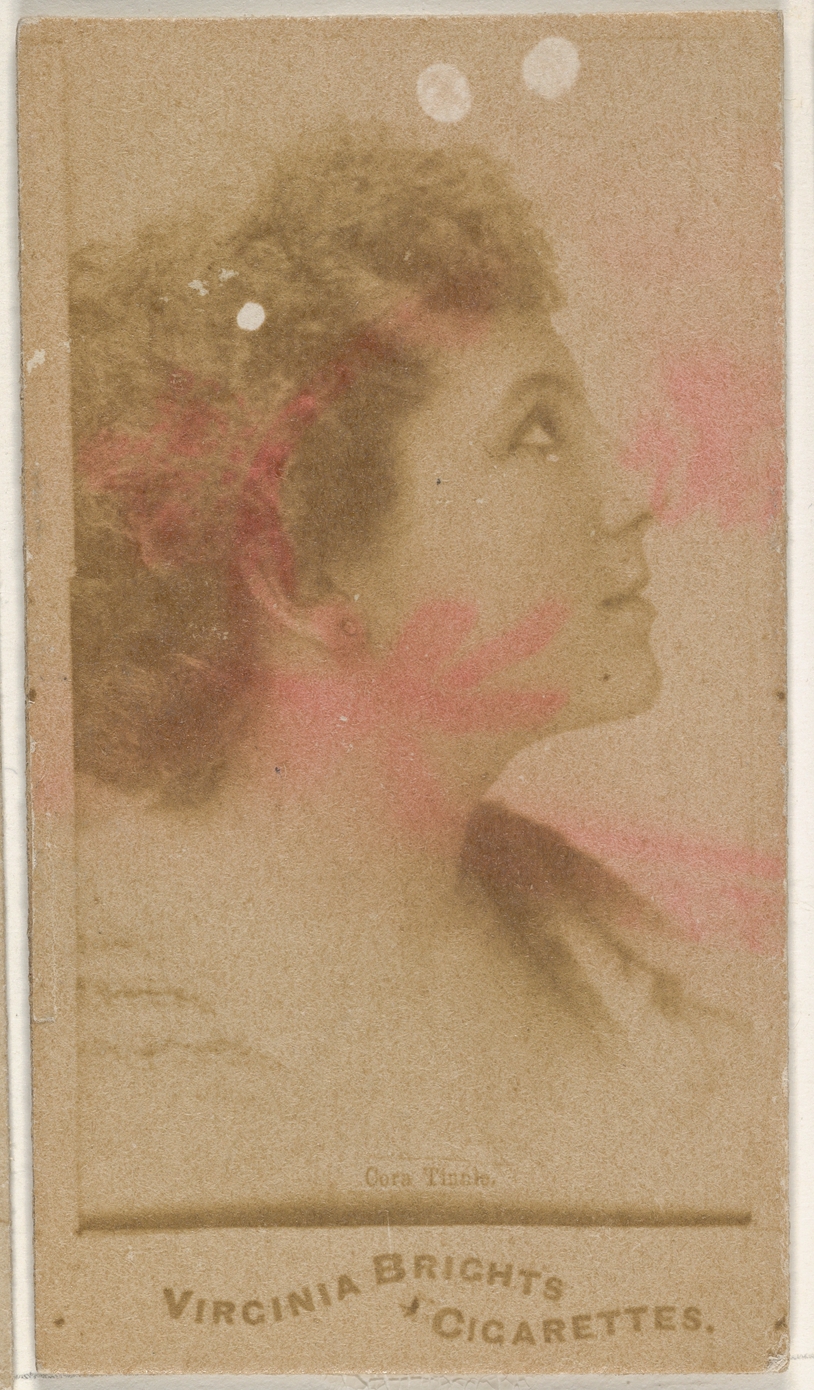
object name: photograph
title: Cora Tisch, from the Actors and Actresses series (N45, Type 1) for Virginia Brights Cigarettes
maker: allen & ginter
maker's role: publisher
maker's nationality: american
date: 1888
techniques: albumen silver print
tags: portraits,women,actresses